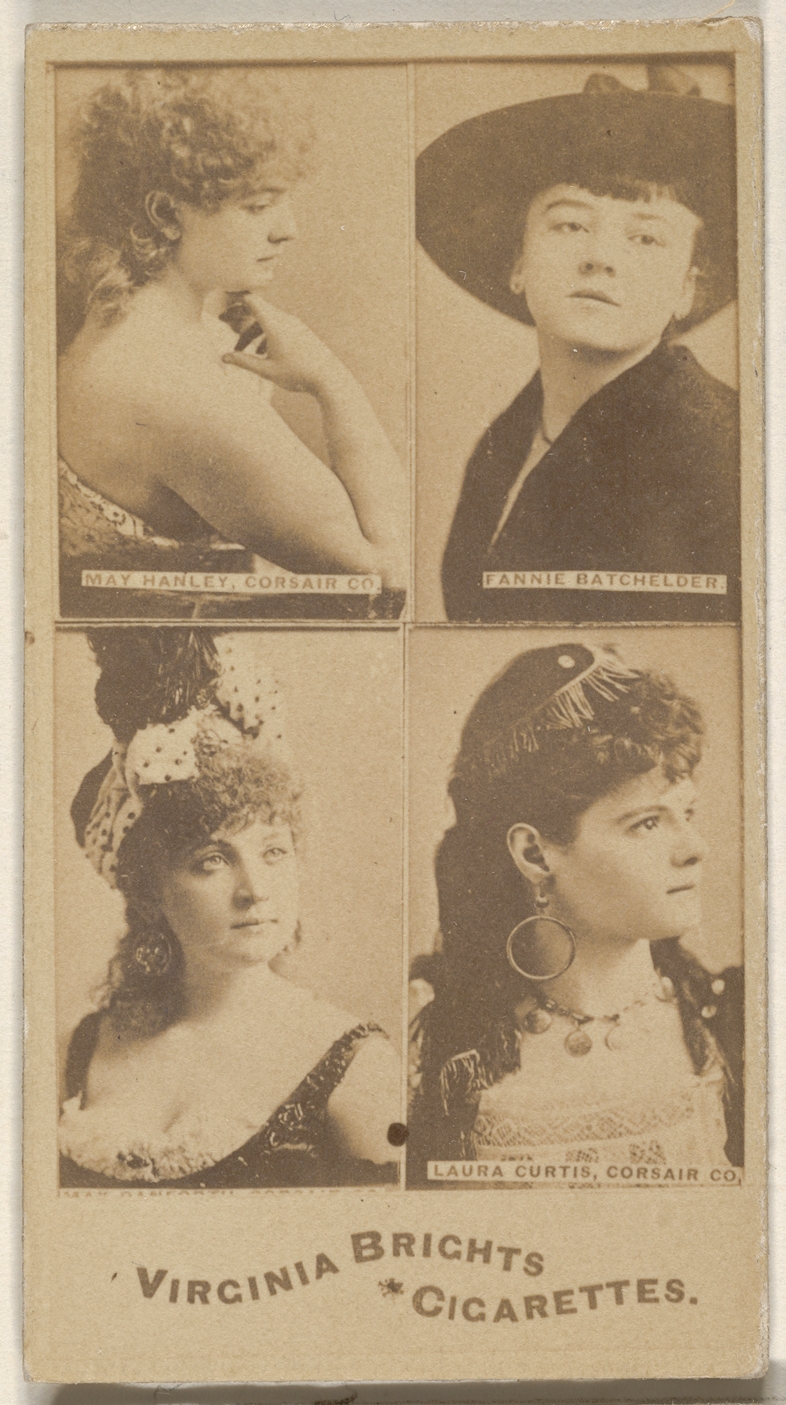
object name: photograph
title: May Hanley, Corsair Co./ Fannie Batchelder/ Laura Curtis, Corsair Co., from the Actors and Actresses series (N45, Type 4) for Virginia Brights Cigarettes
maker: allen & ginter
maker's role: publisher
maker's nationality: american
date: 1888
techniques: albumen silver print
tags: portraits,women